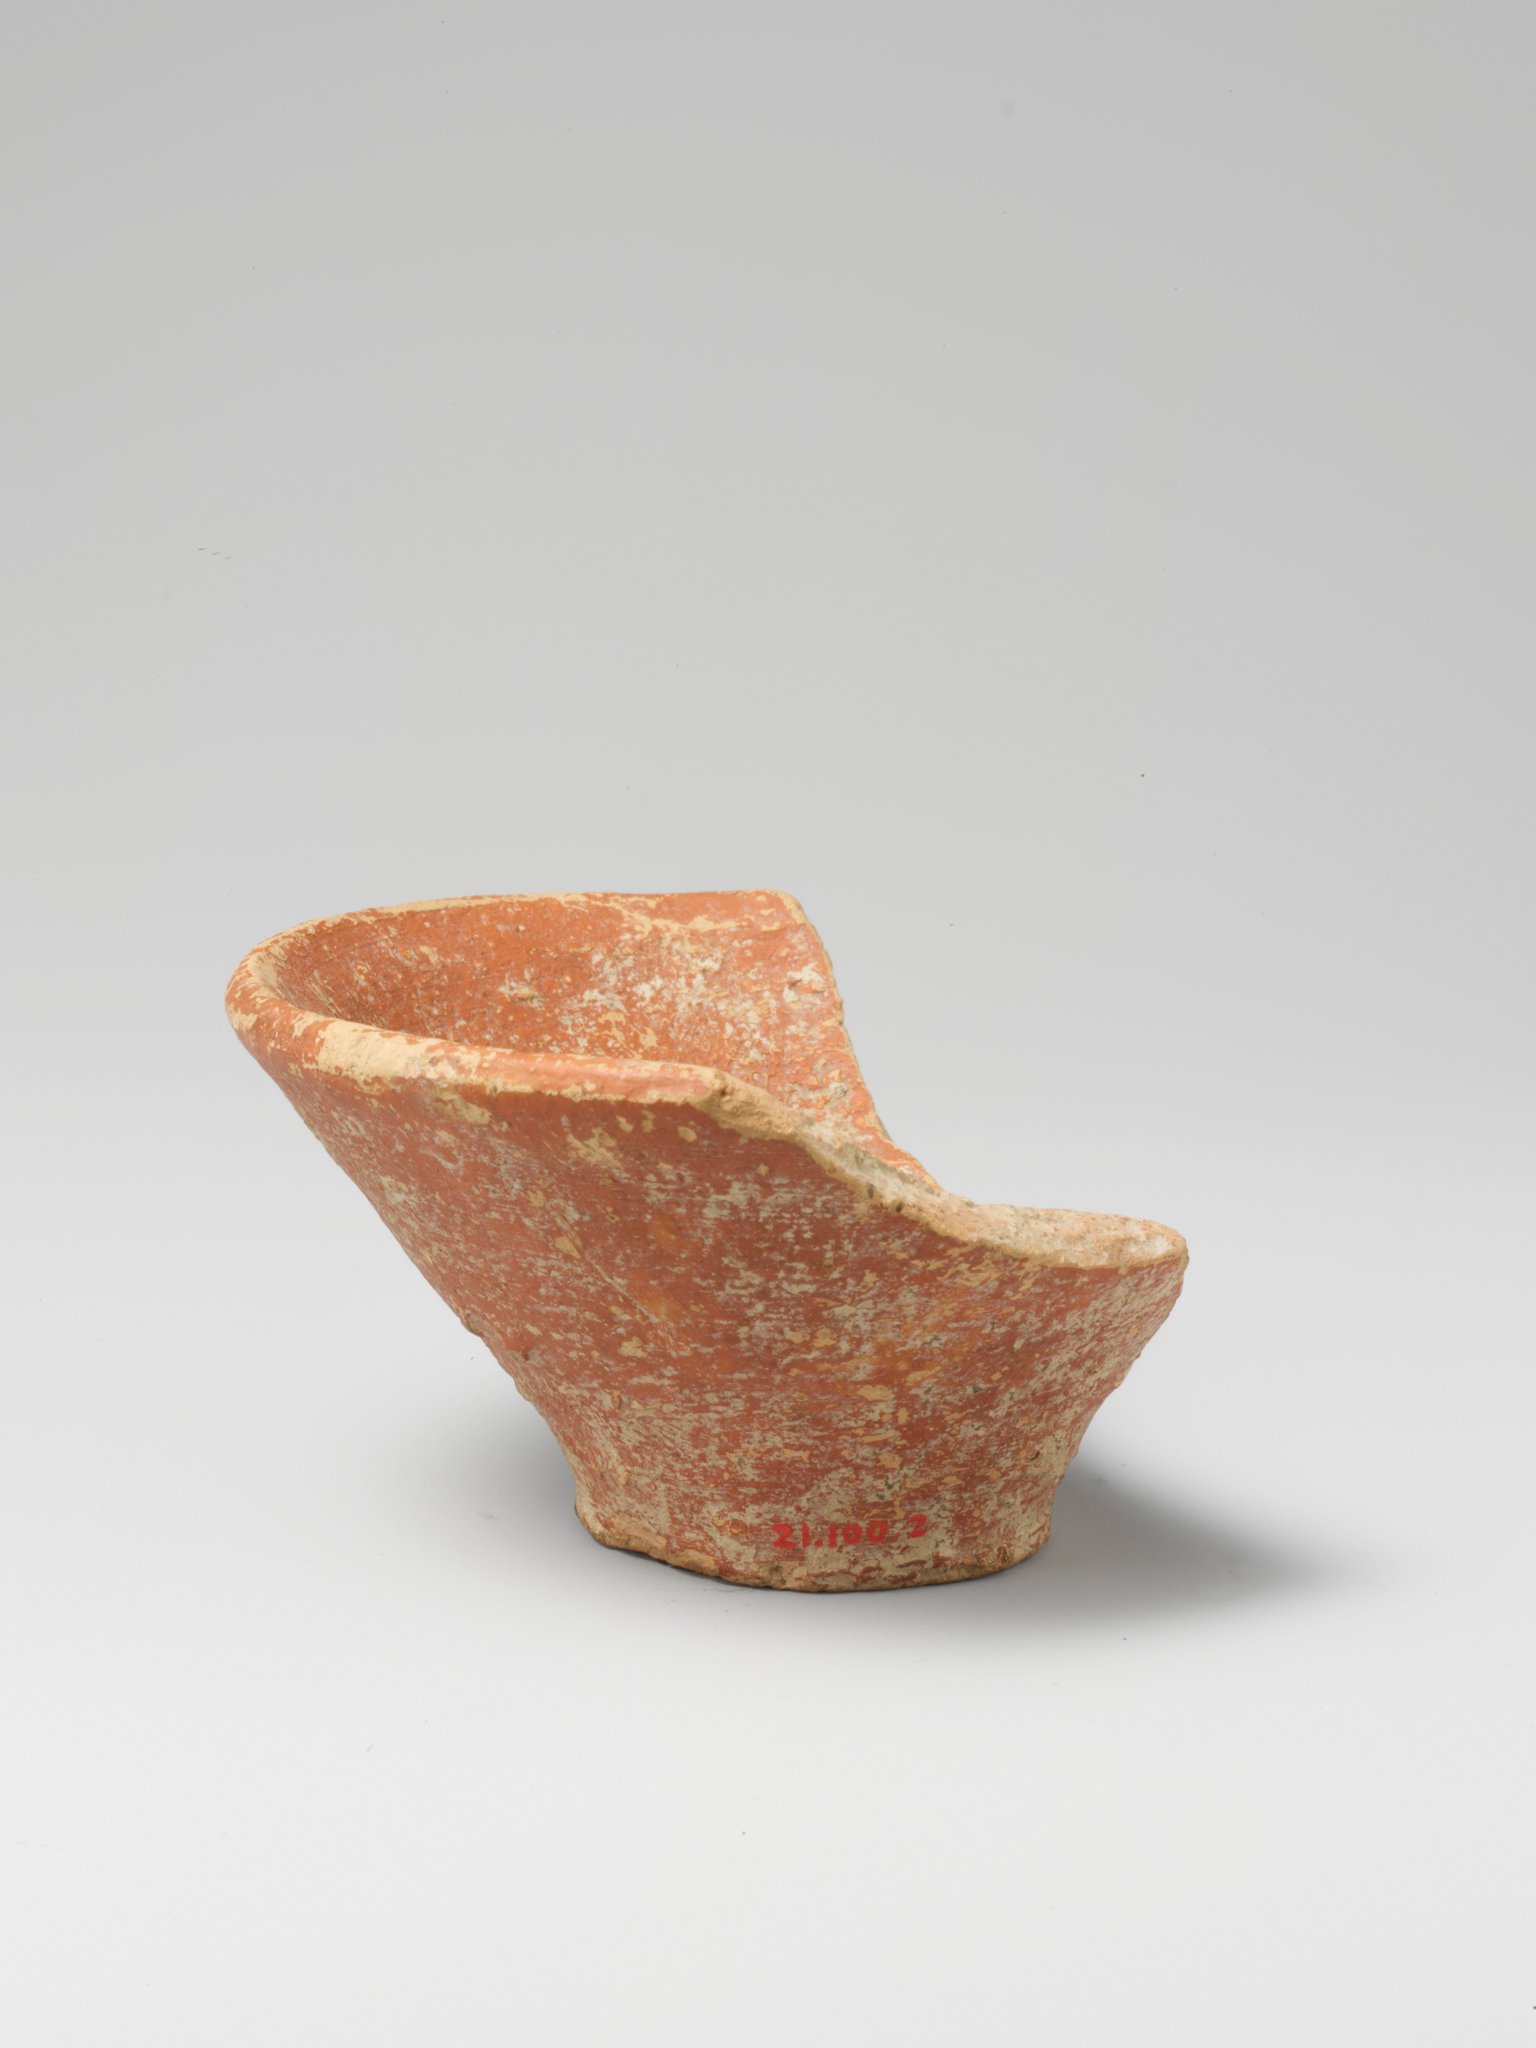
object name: vase fragment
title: Terracotta conical cup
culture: minoan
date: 2200-1900 BCE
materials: terracotta